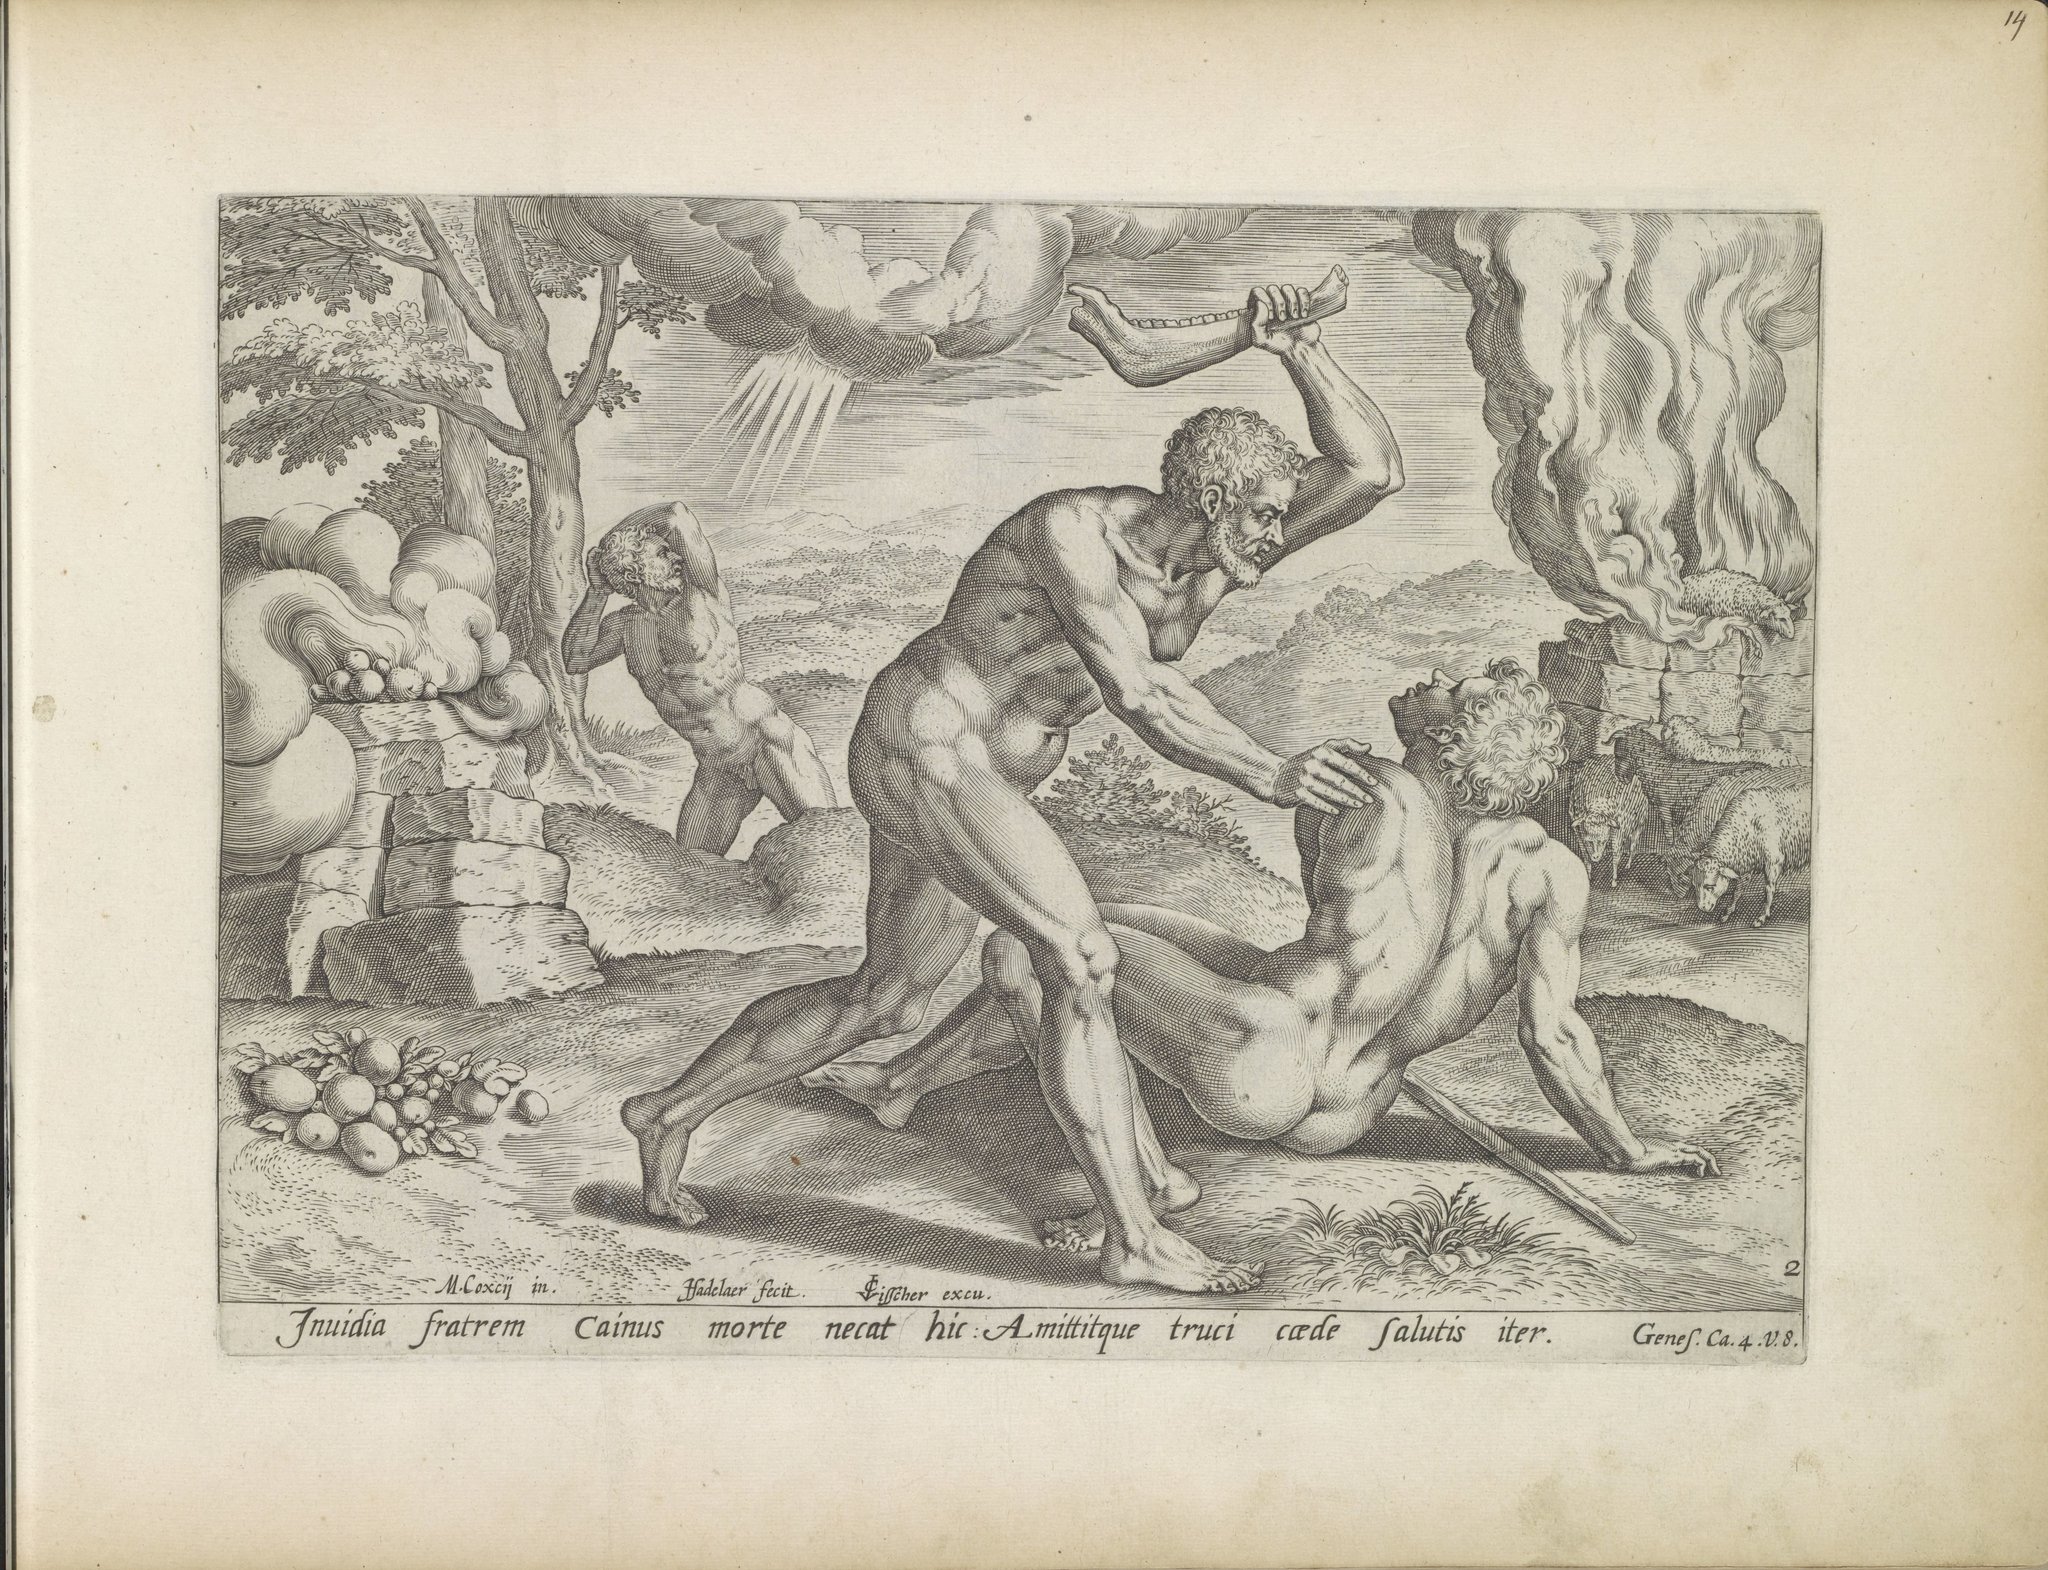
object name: print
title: Theatrum Biblicum Hoc Est Historiae Sacrae Veteris et Novi Testamenti Tabulis Aeneis Expressae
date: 1643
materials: paper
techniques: engraving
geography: amsterdam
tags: the killing of abel: cain slays him with a stone, a club or a jaw-bone, alternatively with a spade or another tool as weapon, the curse and flight of cain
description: Kaïn slaat zijn broer Abel dood met het kaakbeen van een ezel. Op de achtergrond zijn twee offeraltaren te zien. Kaïns offer wordt geweigerd, de rook gaat naar beneden. Het offer van Abel wordt wel door God geaccepteerd. Op de achtergrond verschijnt God als een lichtstraal uit de hemel aan Kaïn. Onderaan een verwijzing naar de Bijbeltekst in Gen. 4 in het Latijn. Deze prent maakt deel uit van een album.